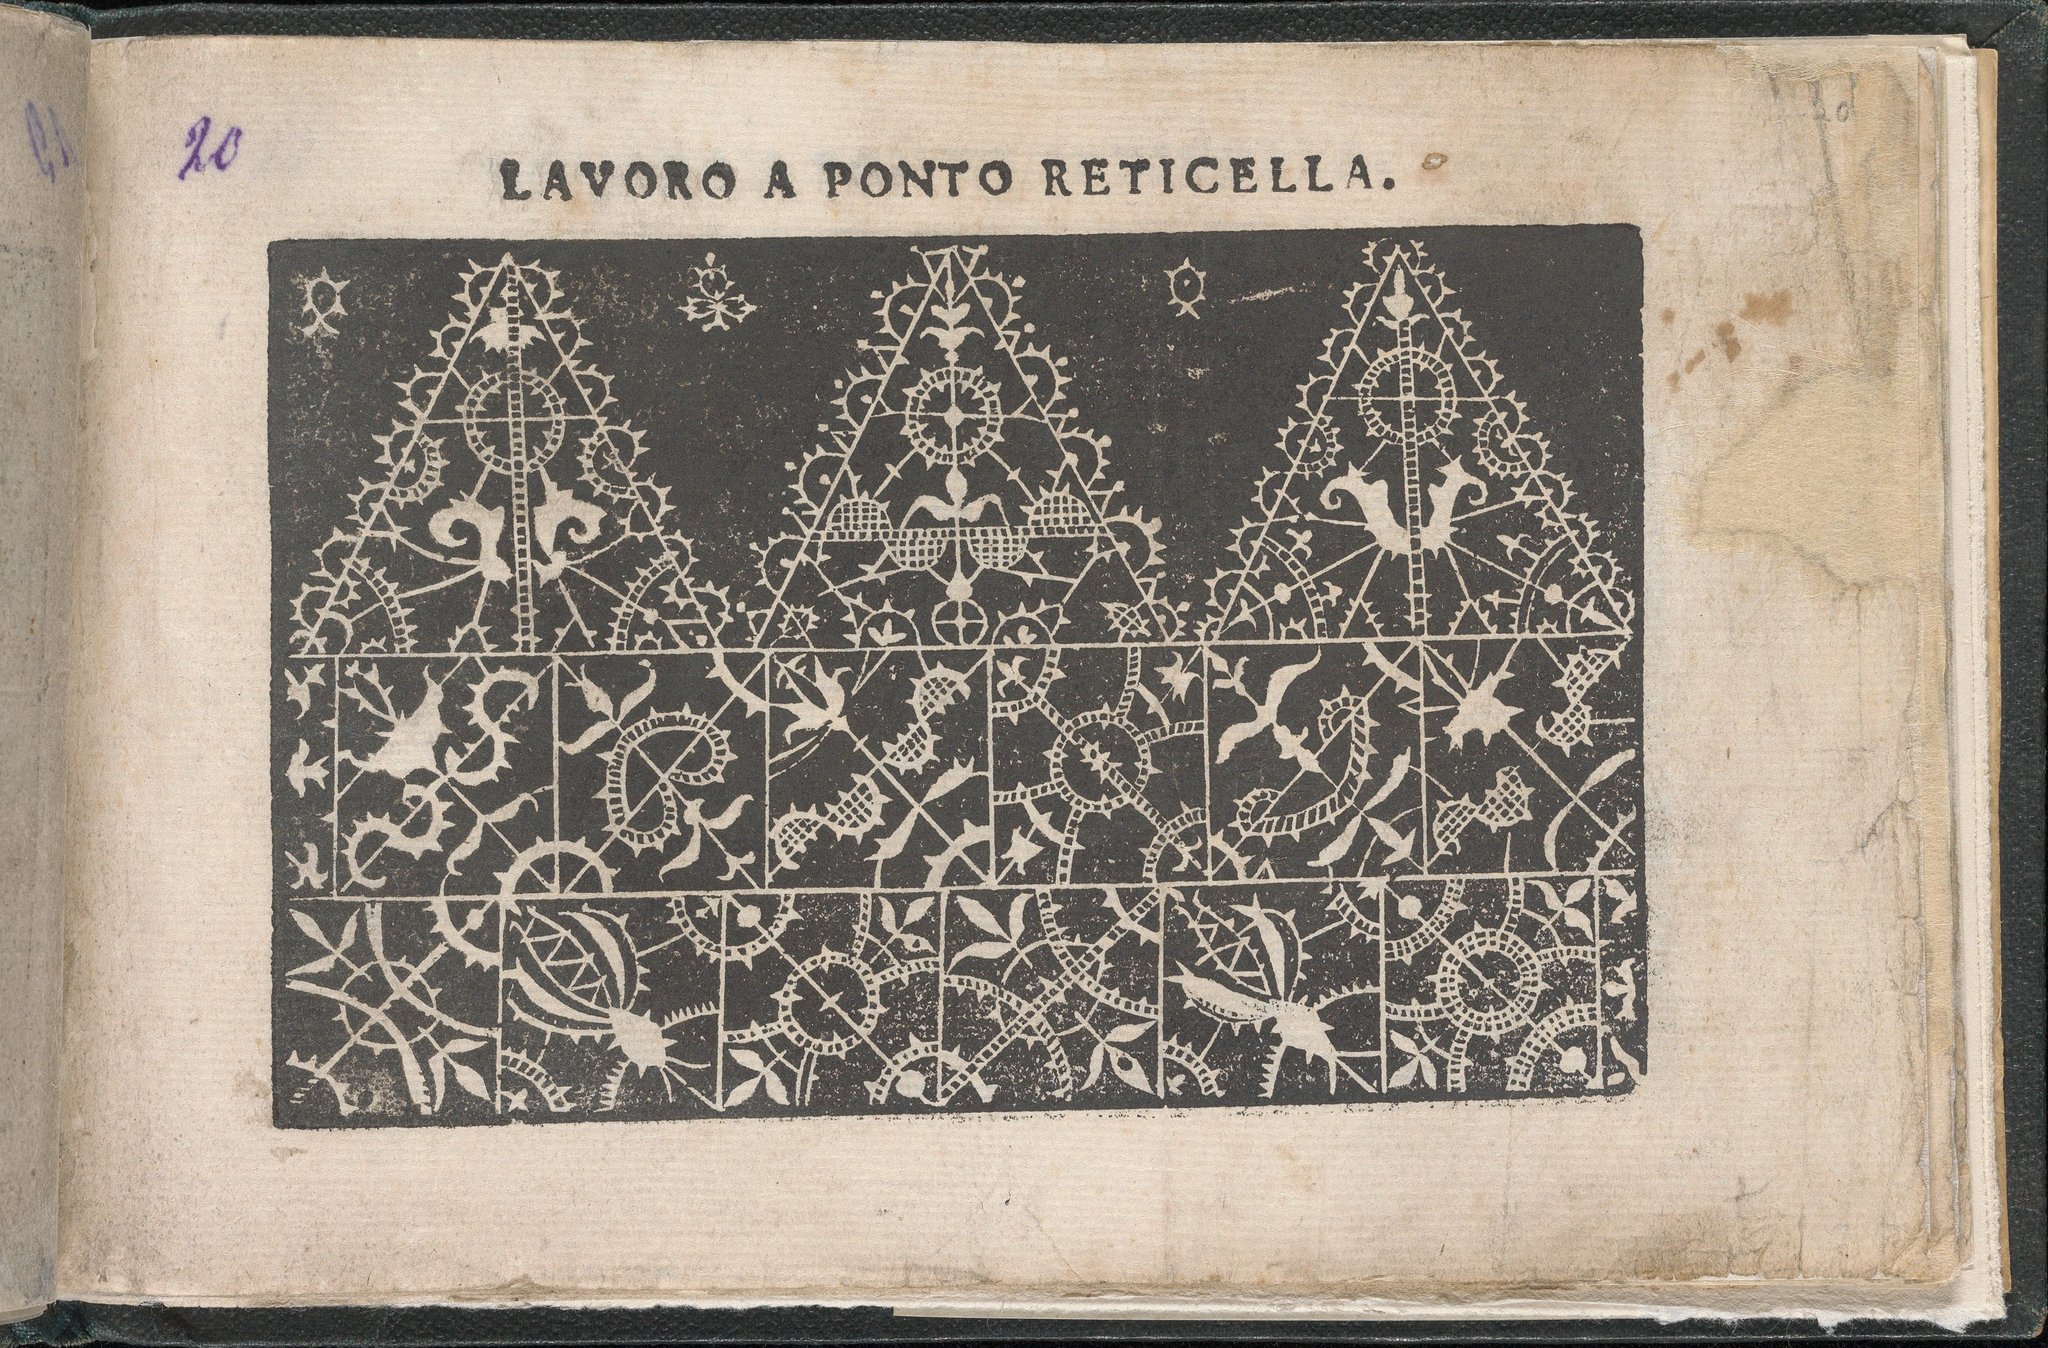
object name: book print ornament architecture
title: Gemma pretiosa della virtuose donne, page 20 (recto)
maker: isabella catanea parasole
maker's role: designer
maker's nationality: italian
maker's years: 1565-1625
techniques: woodcut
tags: ornament